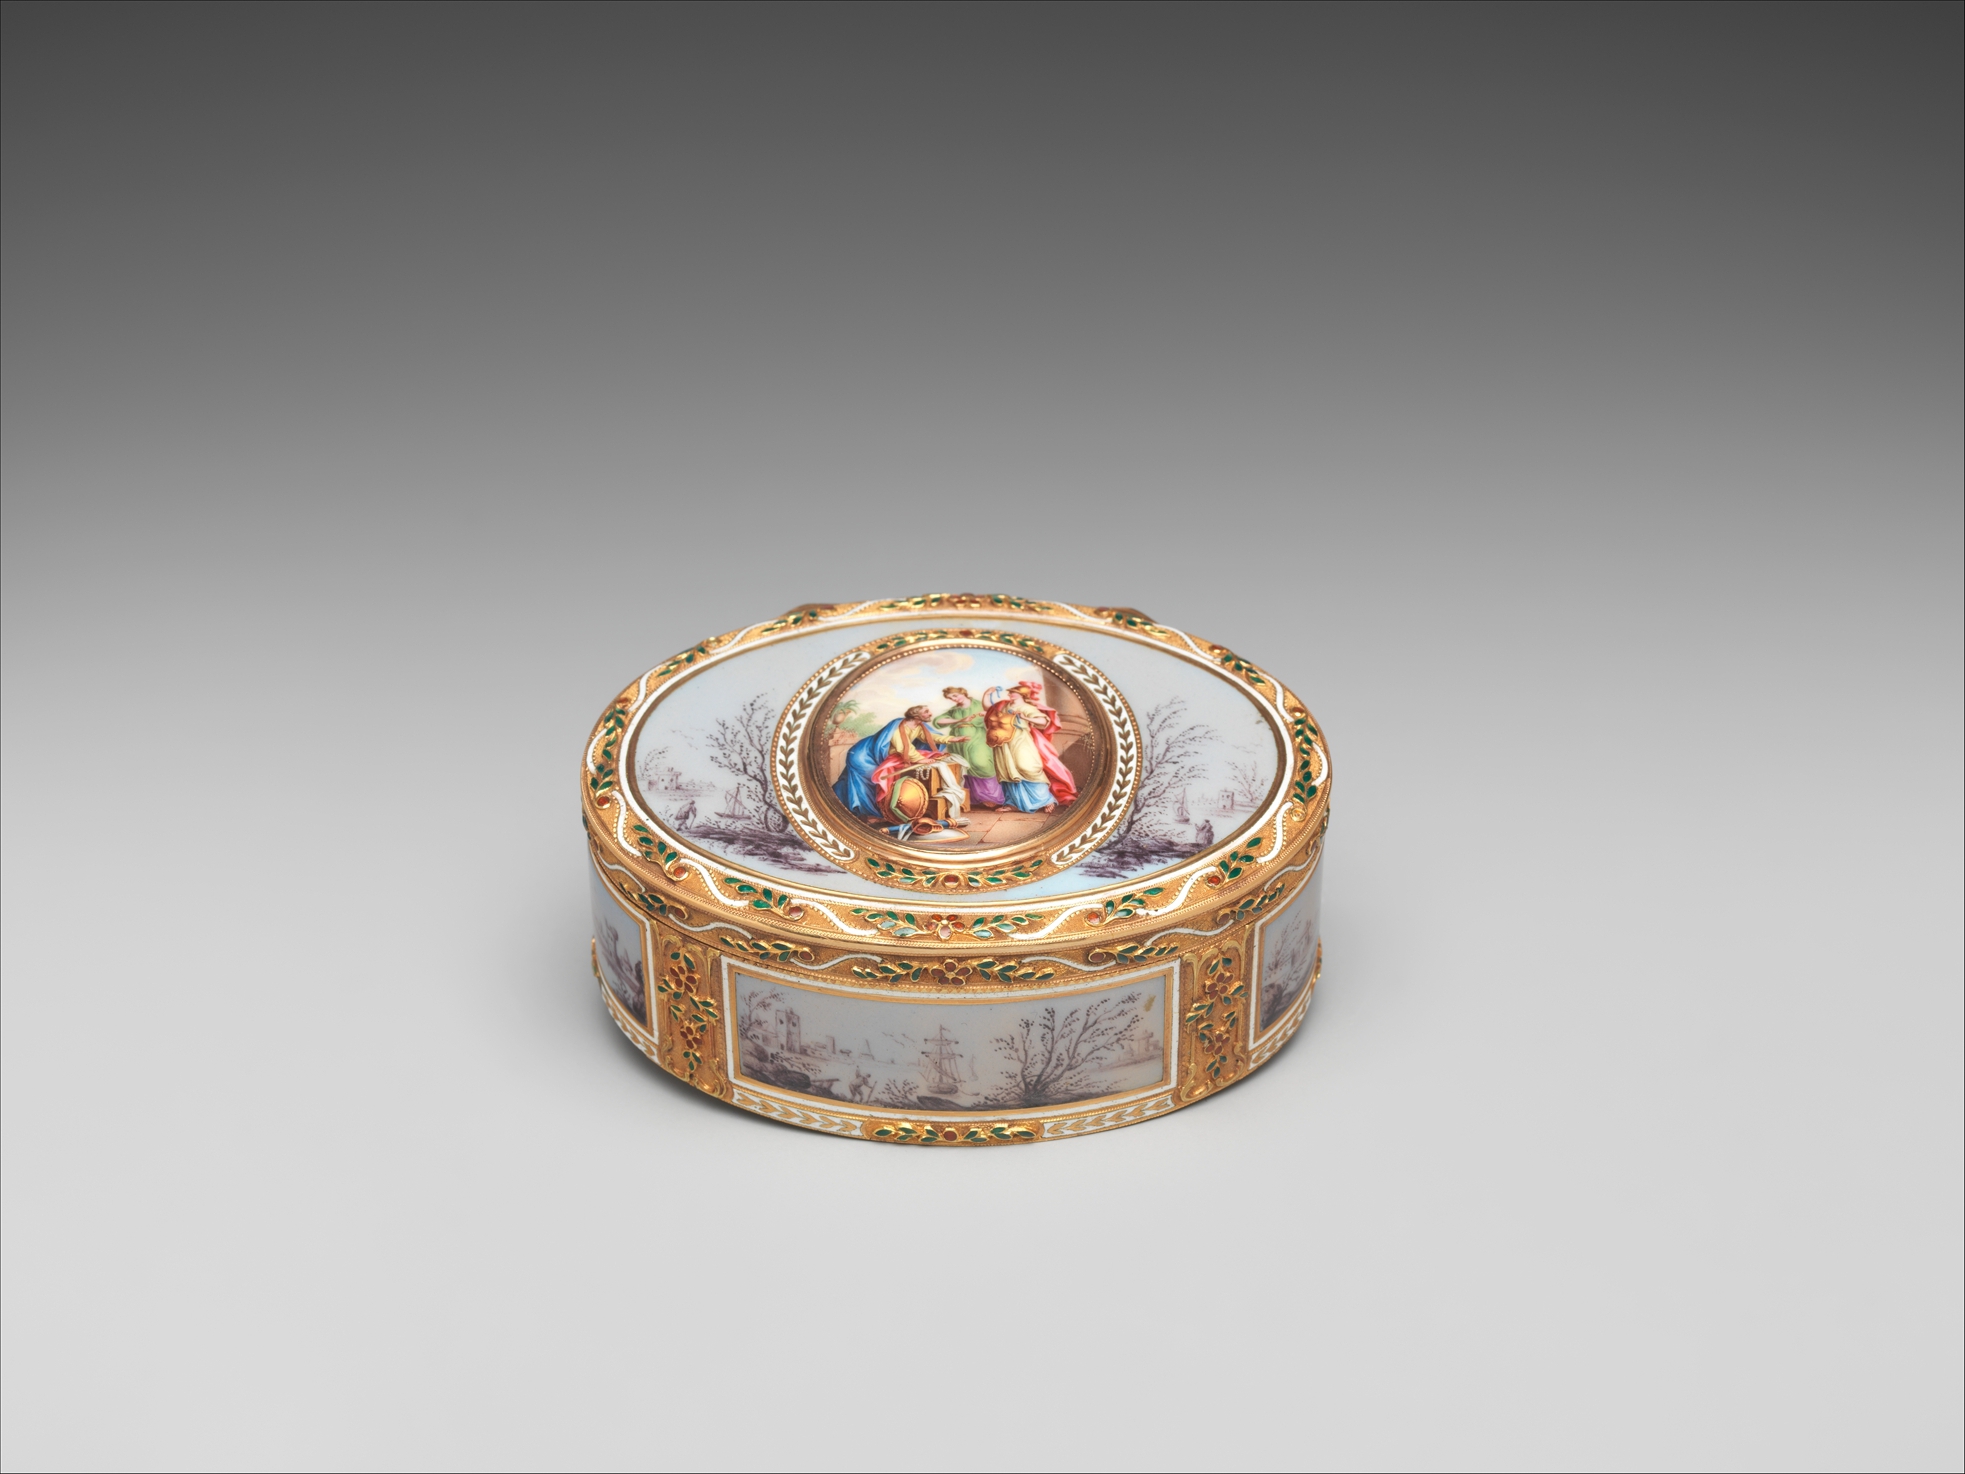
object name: snuffbox, painting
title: Snuffbox with Ulysses discovering Achilles and harbor scenes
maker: les frères souchay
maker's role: maker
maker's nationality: swiss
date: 1780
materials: enamel, gold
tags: men,women,ships